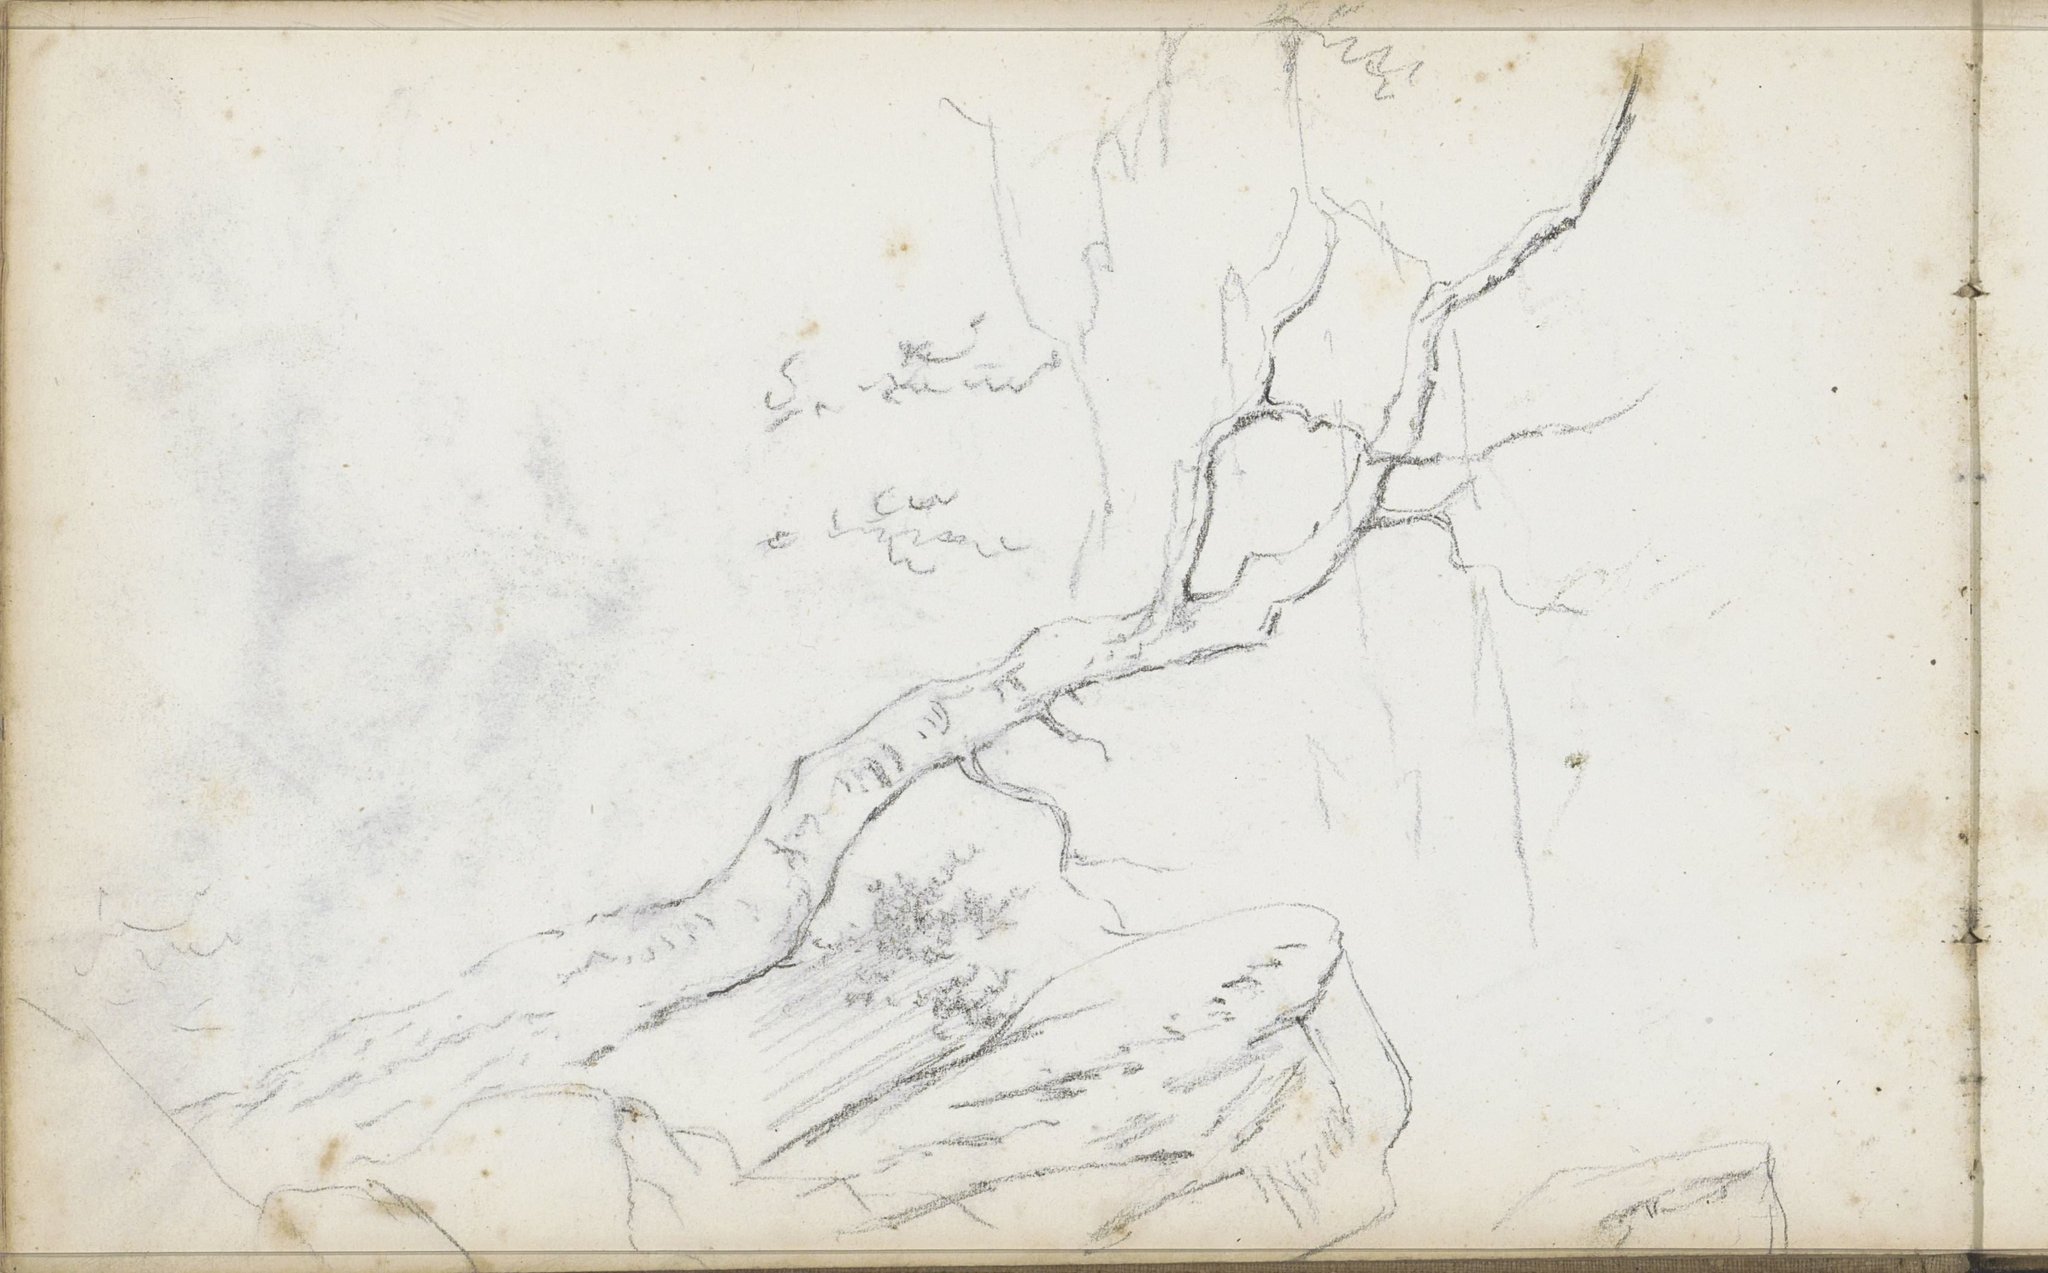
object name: sketchbook leaf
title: Boom en een kei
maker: willem cornelis rip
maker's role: draughtsman, painter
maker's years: 1856-1922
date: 1874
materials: paper, pencil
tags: trees, boulder, stone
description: Blad 12 verso uit een schetsboek met 47 bladen.